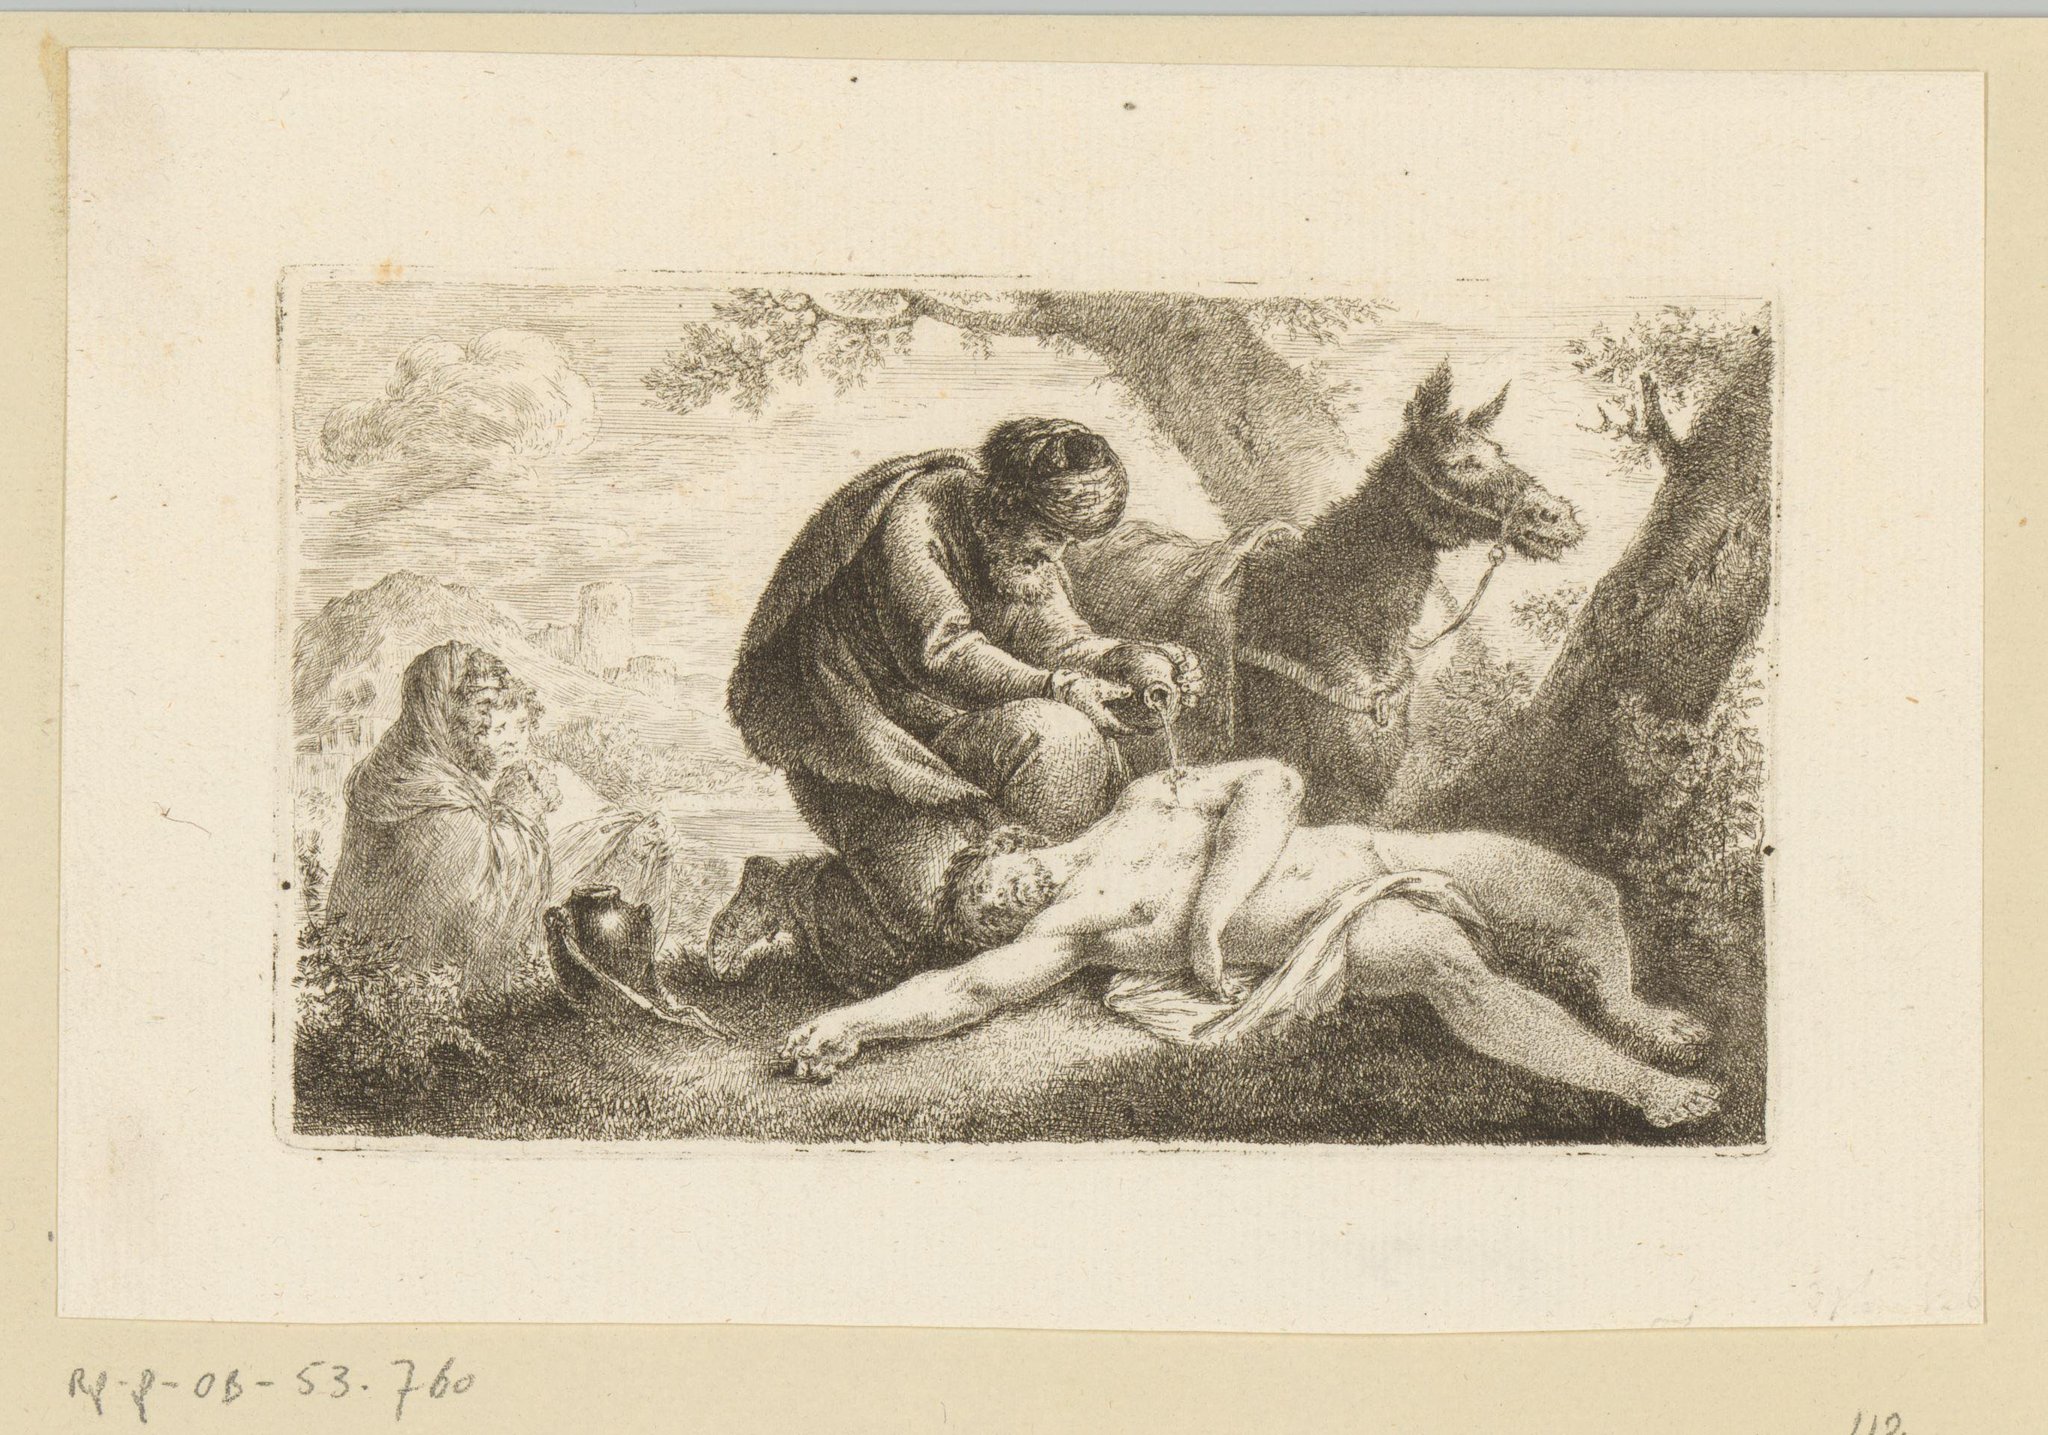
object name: print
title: Barmhartige Samaritaan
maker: bernhard rode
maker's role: artist, print maker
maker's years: 1725-1797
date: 1735-1797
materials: paper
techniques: etching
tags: the good samaritan (luke 10:30-37)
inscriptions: collector's mark: Lugt 240